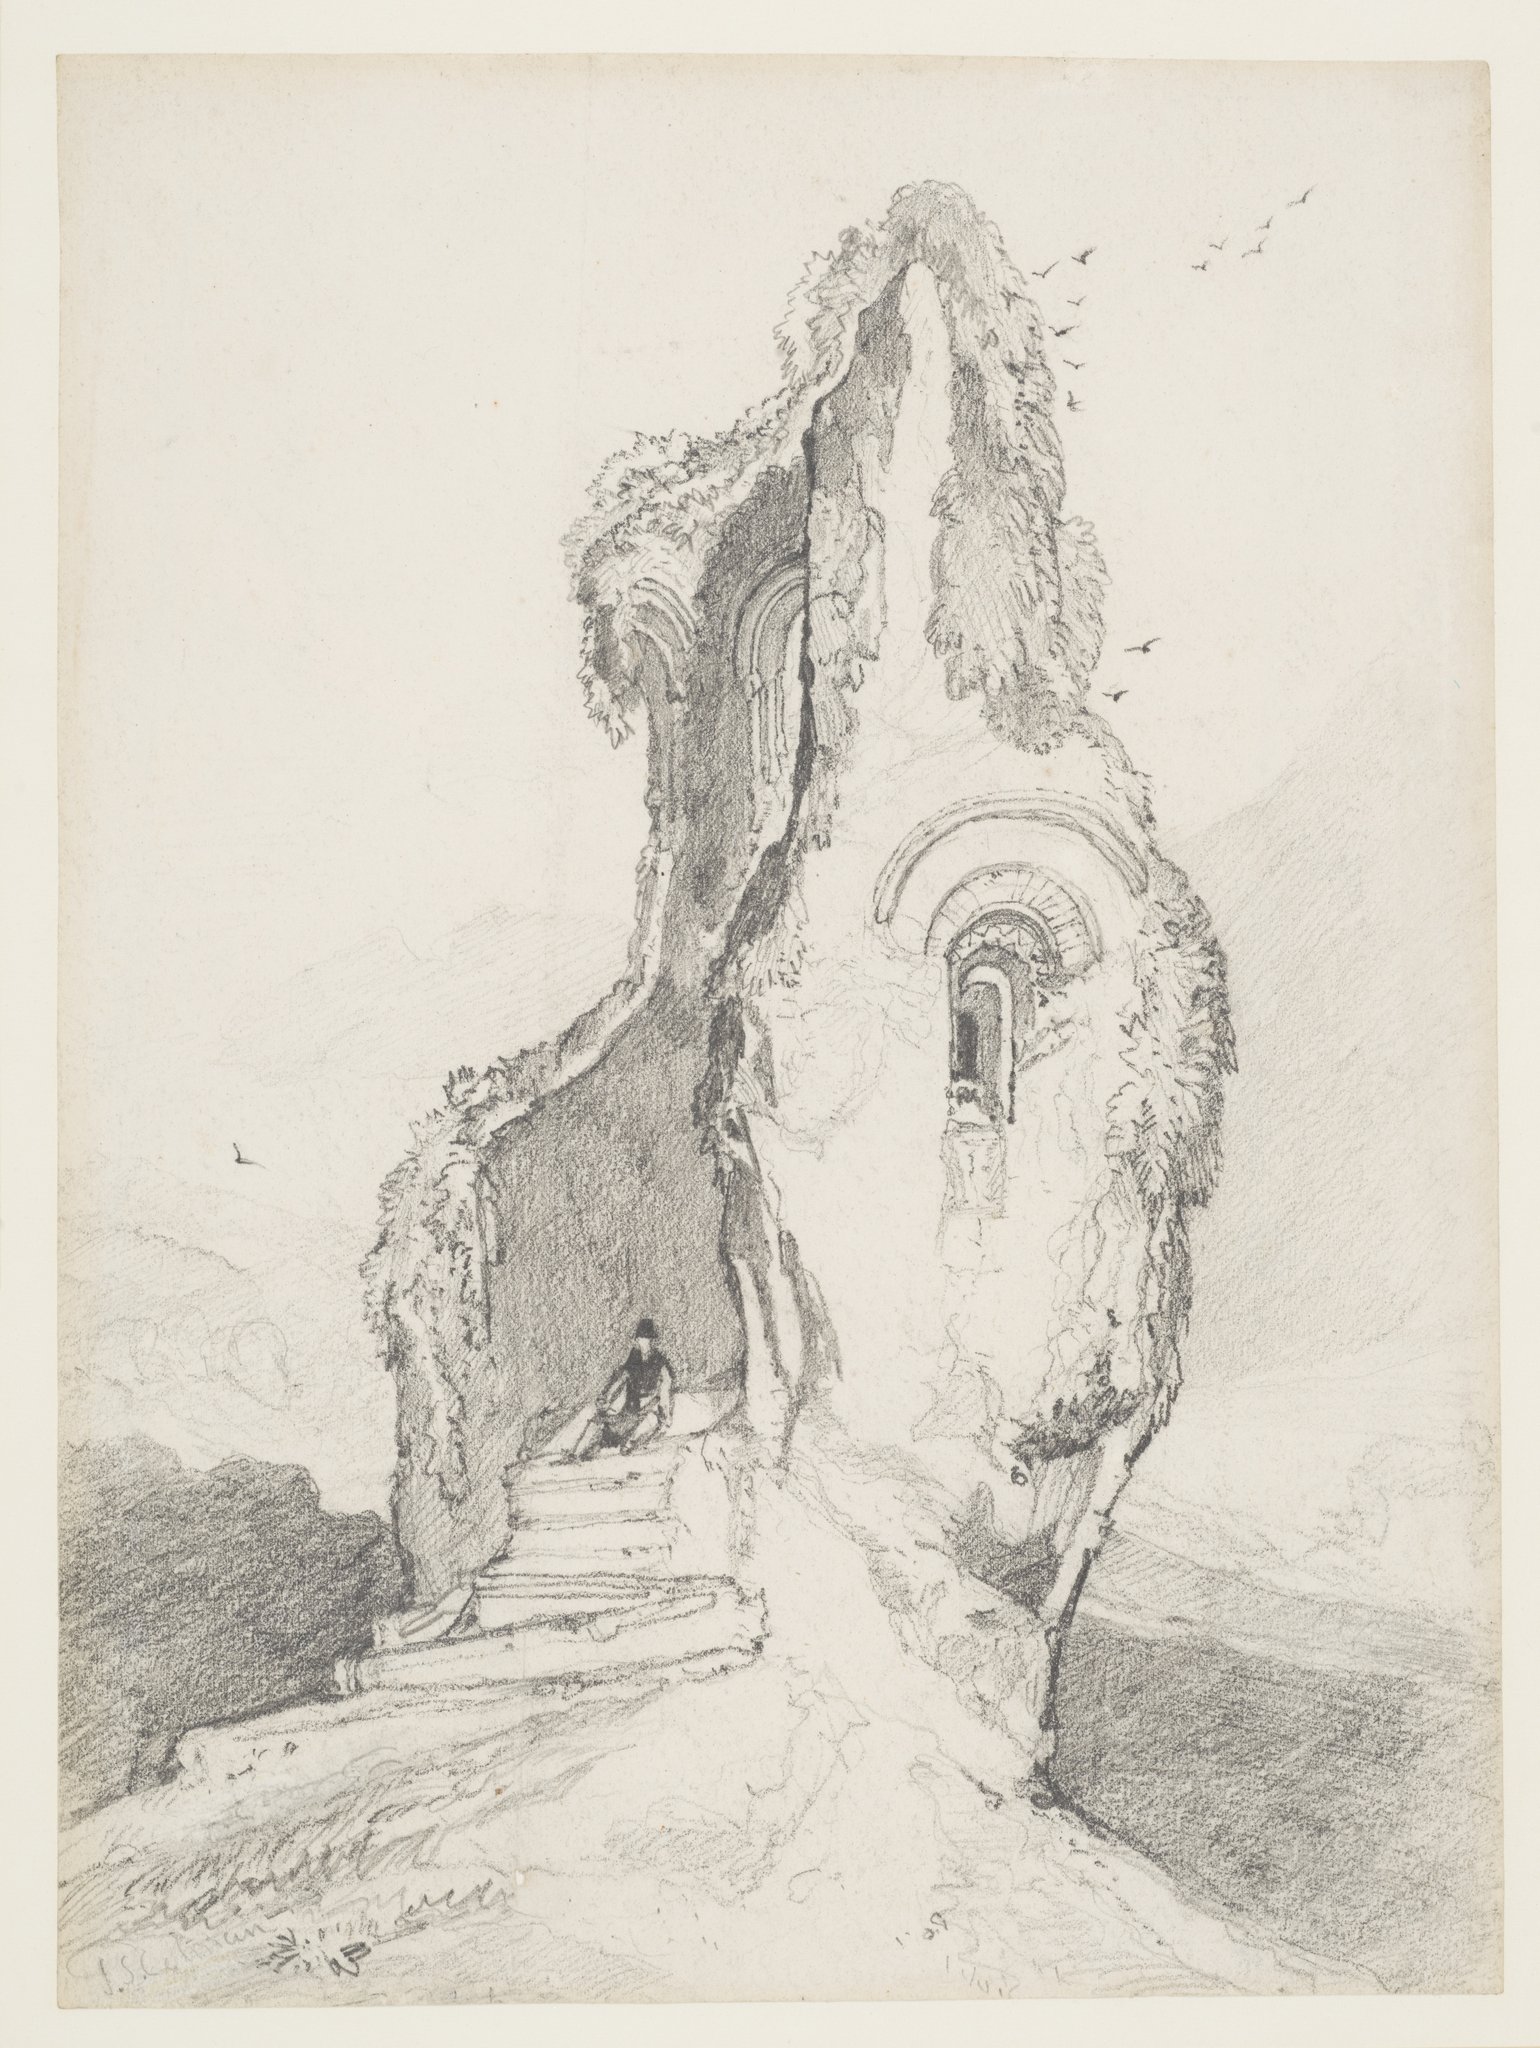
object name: drawing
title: A figure resting in a ruined tower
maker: john sell cotman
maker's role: artist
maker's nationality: british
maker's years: 1782-1842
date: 1810-1840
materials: graphite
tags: towers